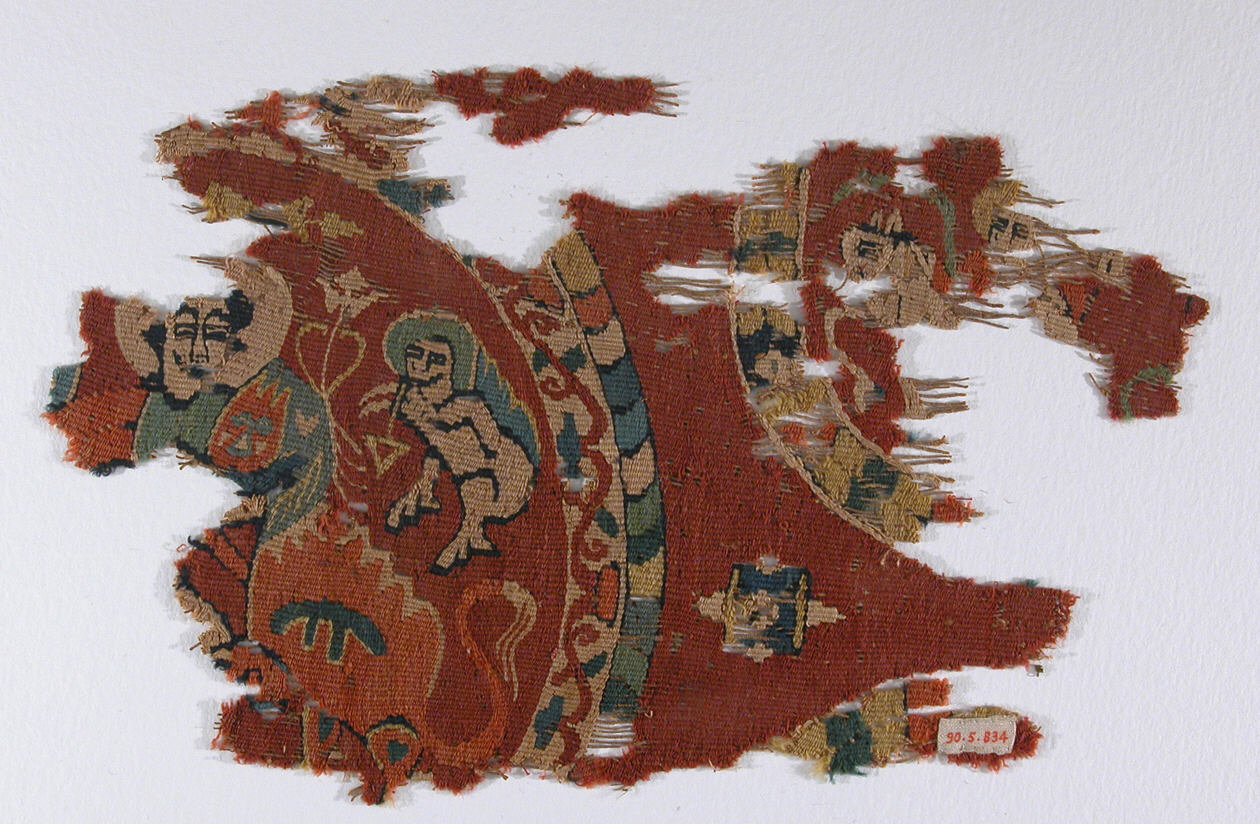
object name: panel fragment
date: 601-700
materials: linen, wool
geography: egypt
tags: faces